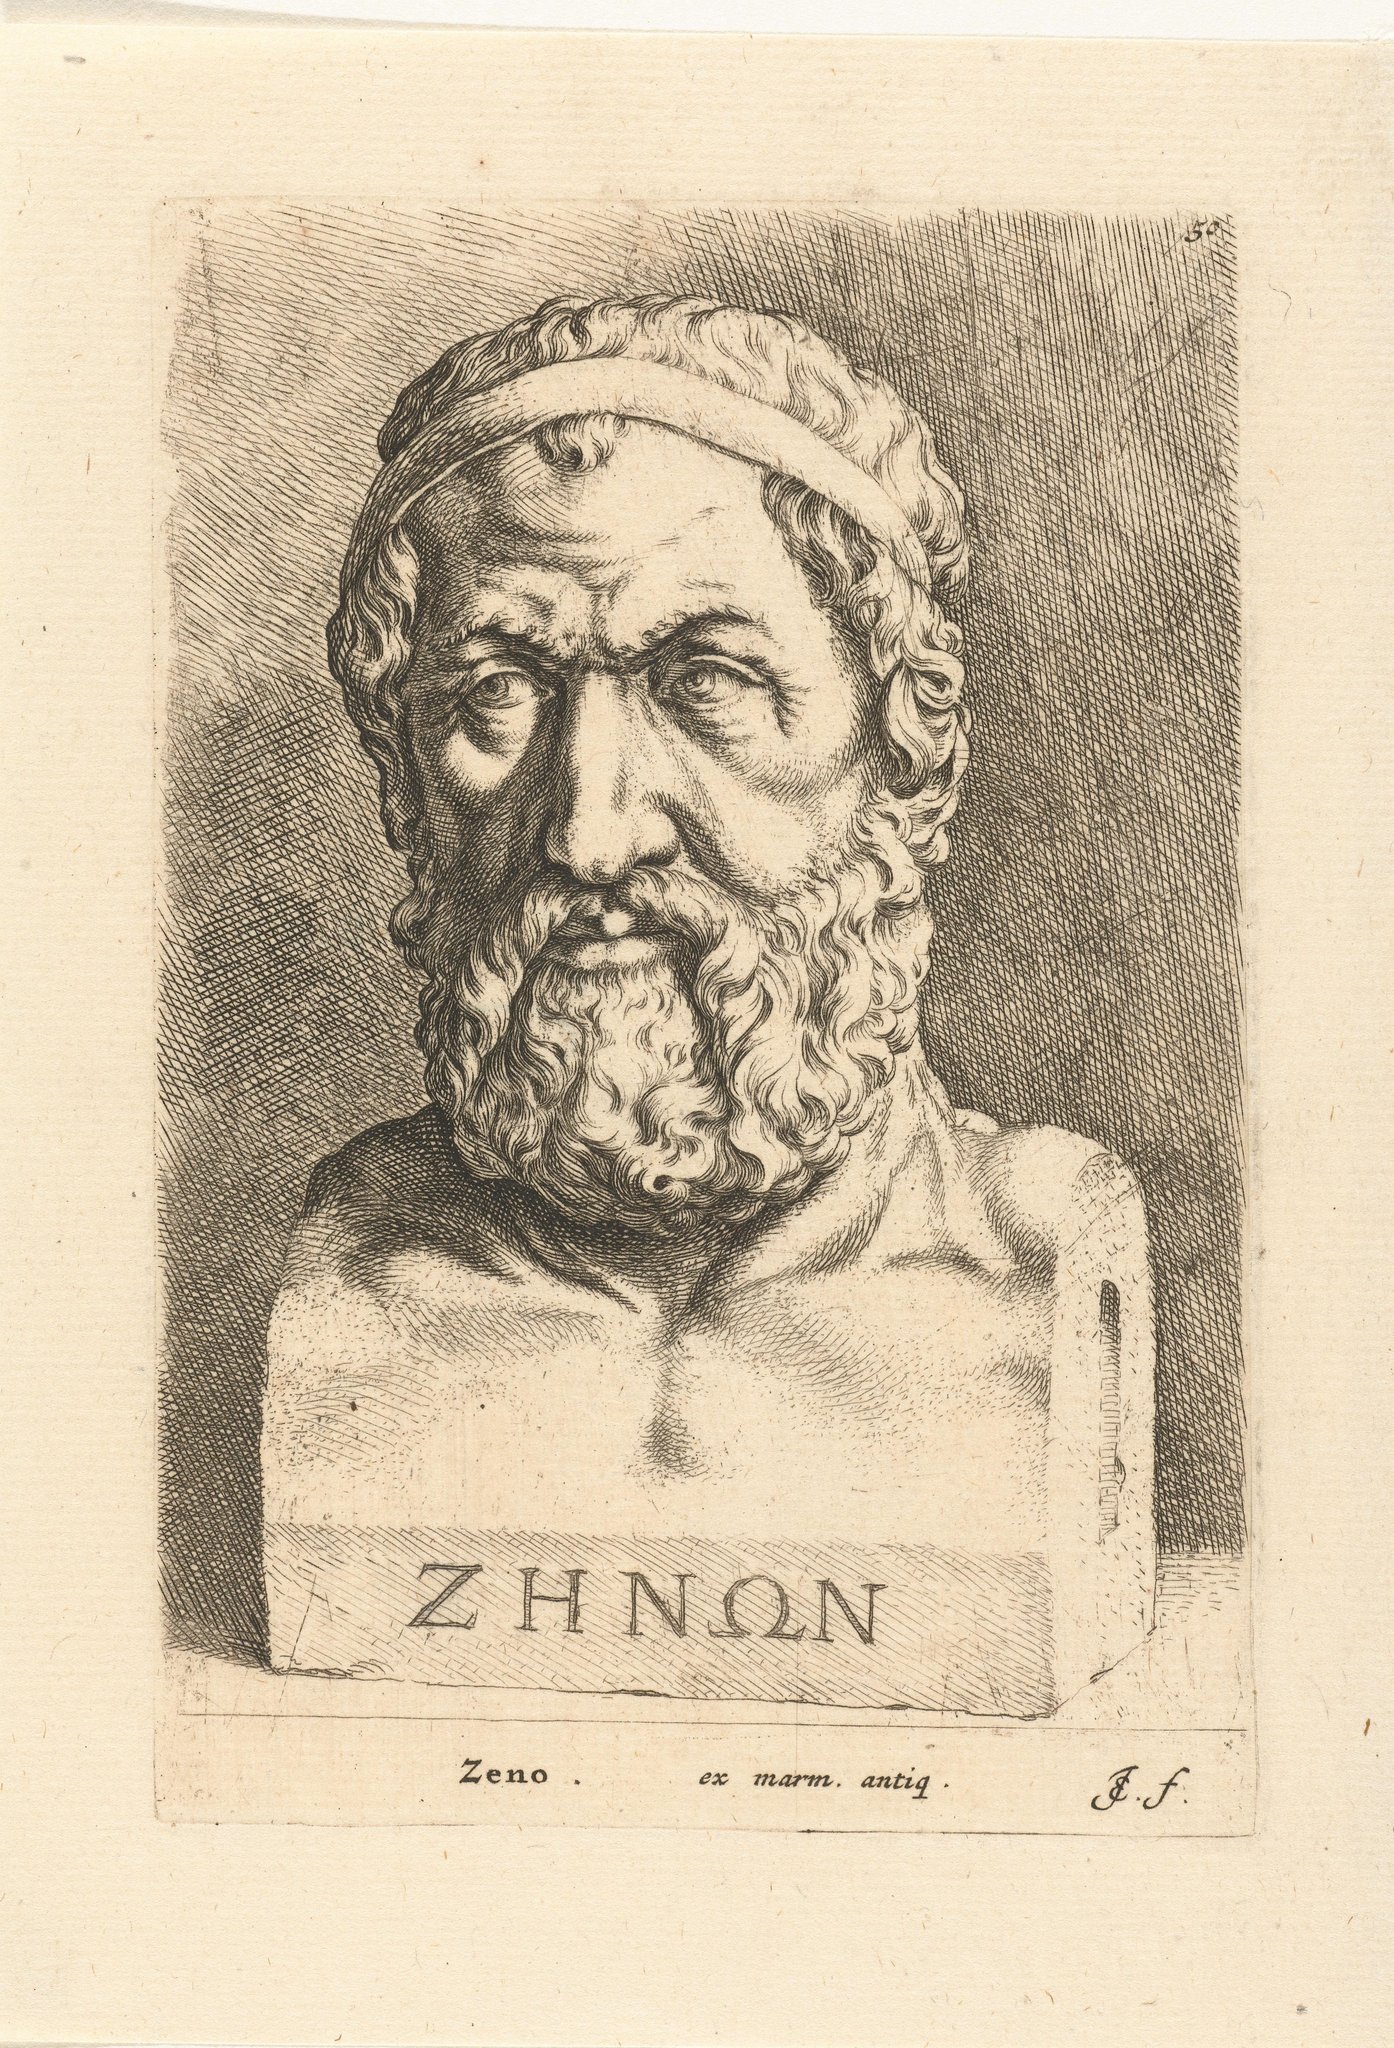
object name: print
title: Portretbuste van Zeno van Elea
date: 1666-1671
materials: paper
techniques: etching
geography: northern netherlands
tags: schrijver, zeno van elea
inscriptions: collector's mark: Lugt 2228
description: afkomstig uit: Paradigmata graphices variorum artificum : voor-beelden der teken-konst van verscheyde meesters, (2e of latere editie)